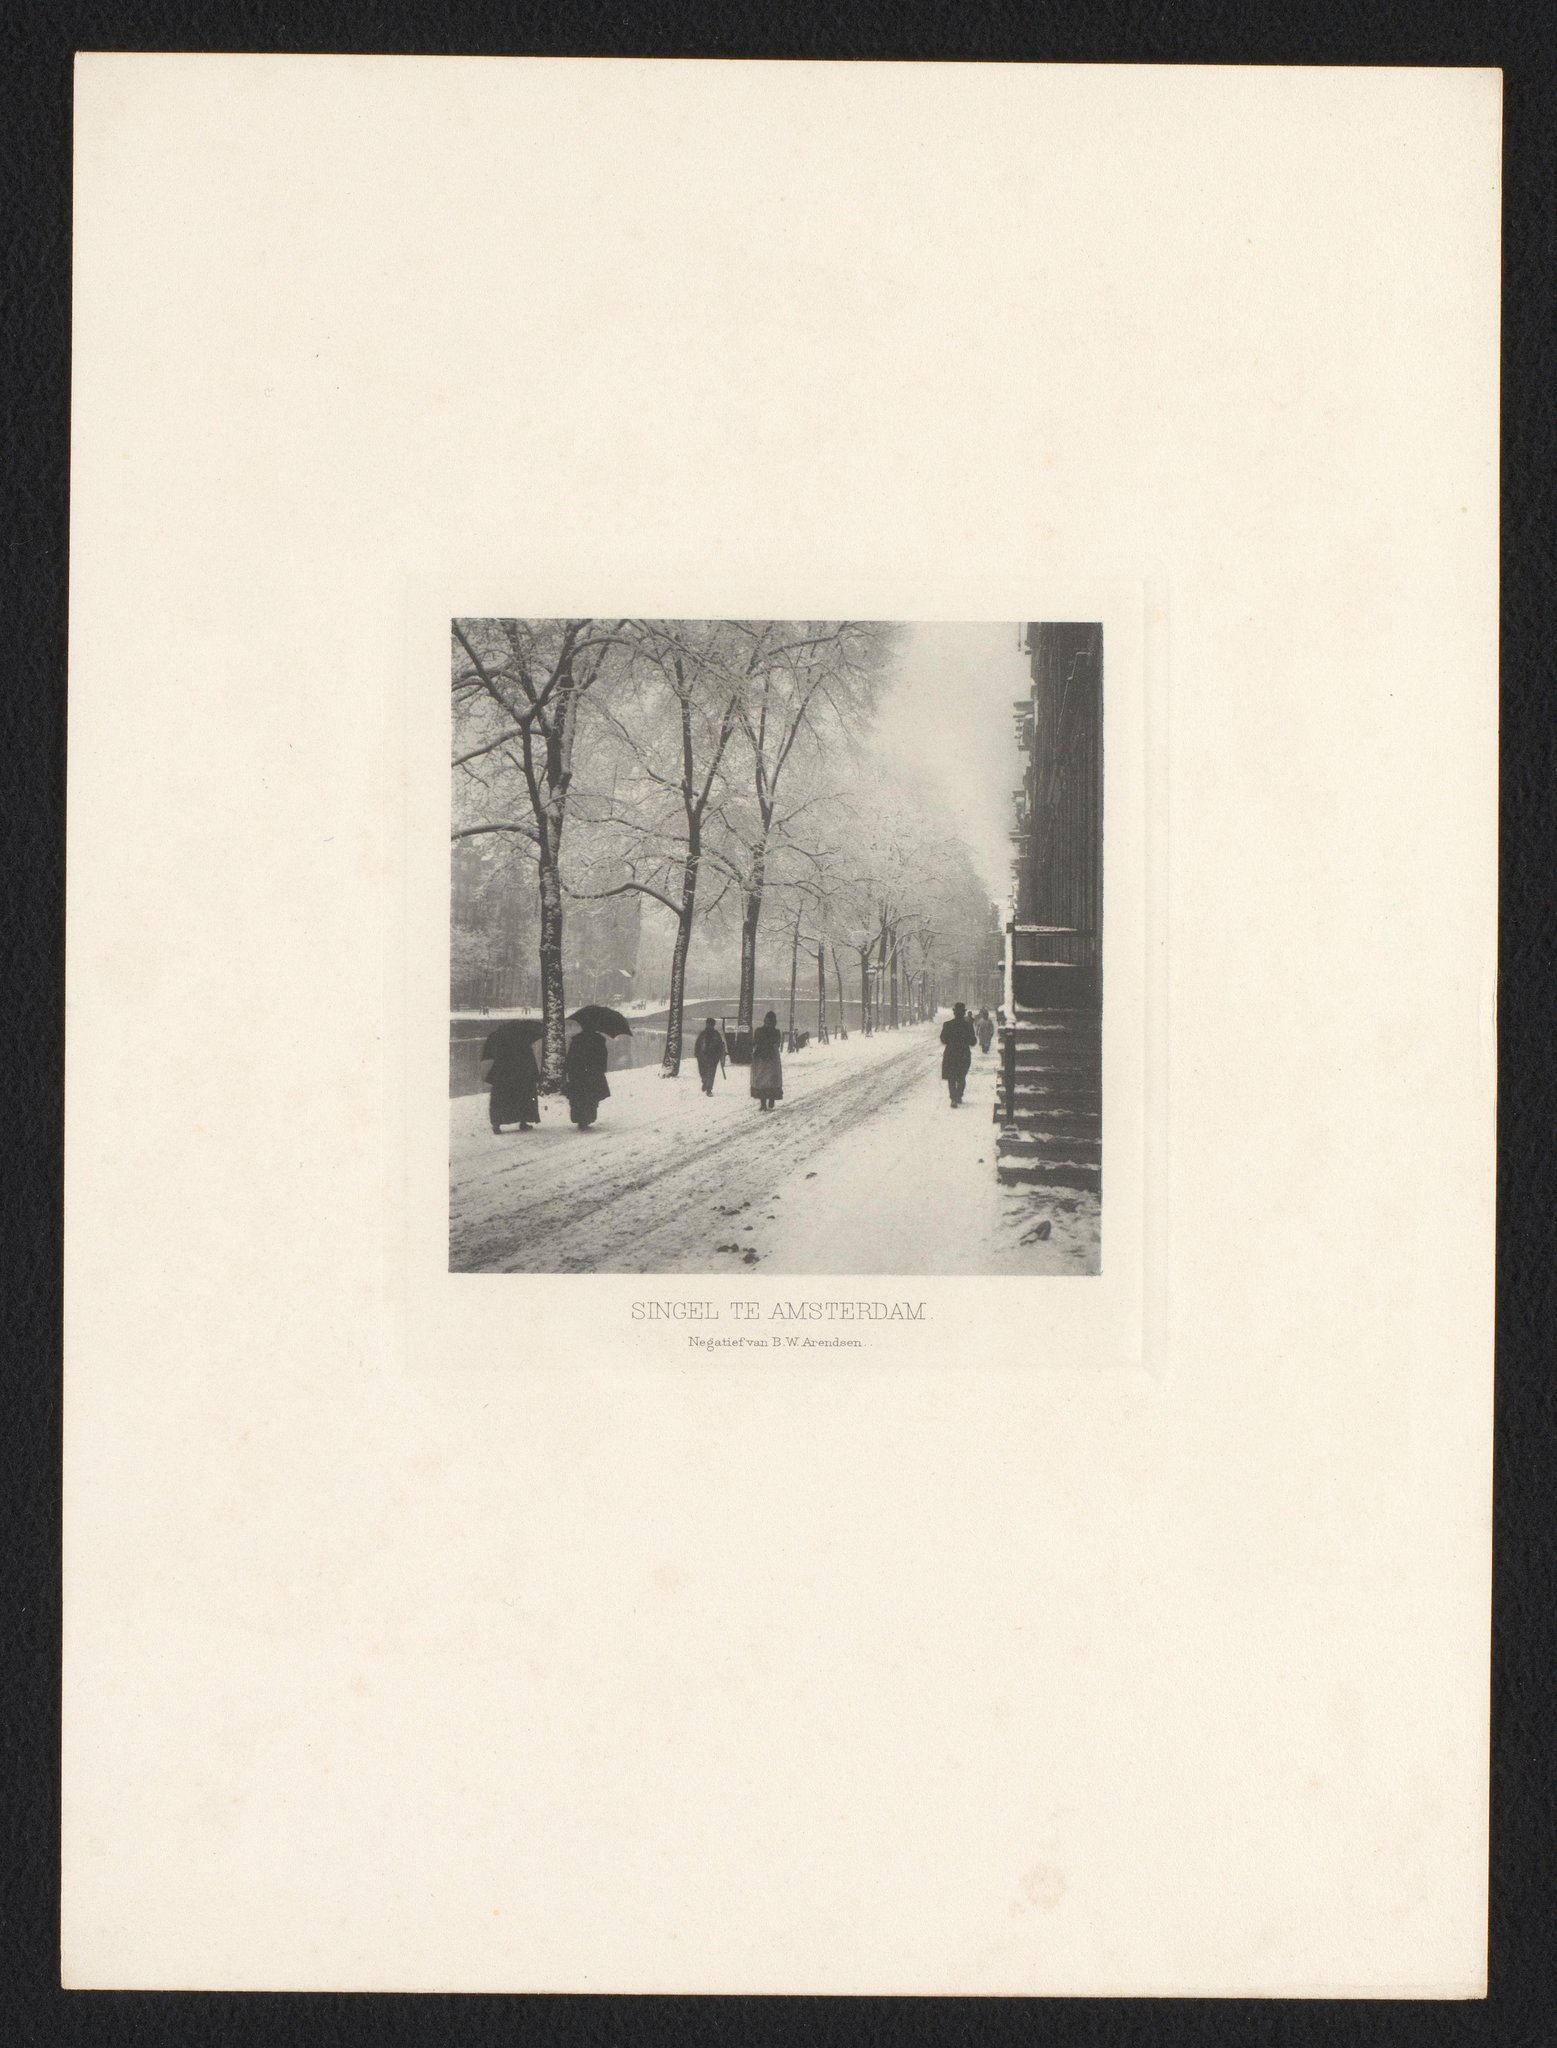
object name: photomechanical print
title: Singel te Amsterdam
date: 1899-1904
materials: paper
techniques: photoaquatint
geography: amsterdam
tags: canals, waters (in city), snow